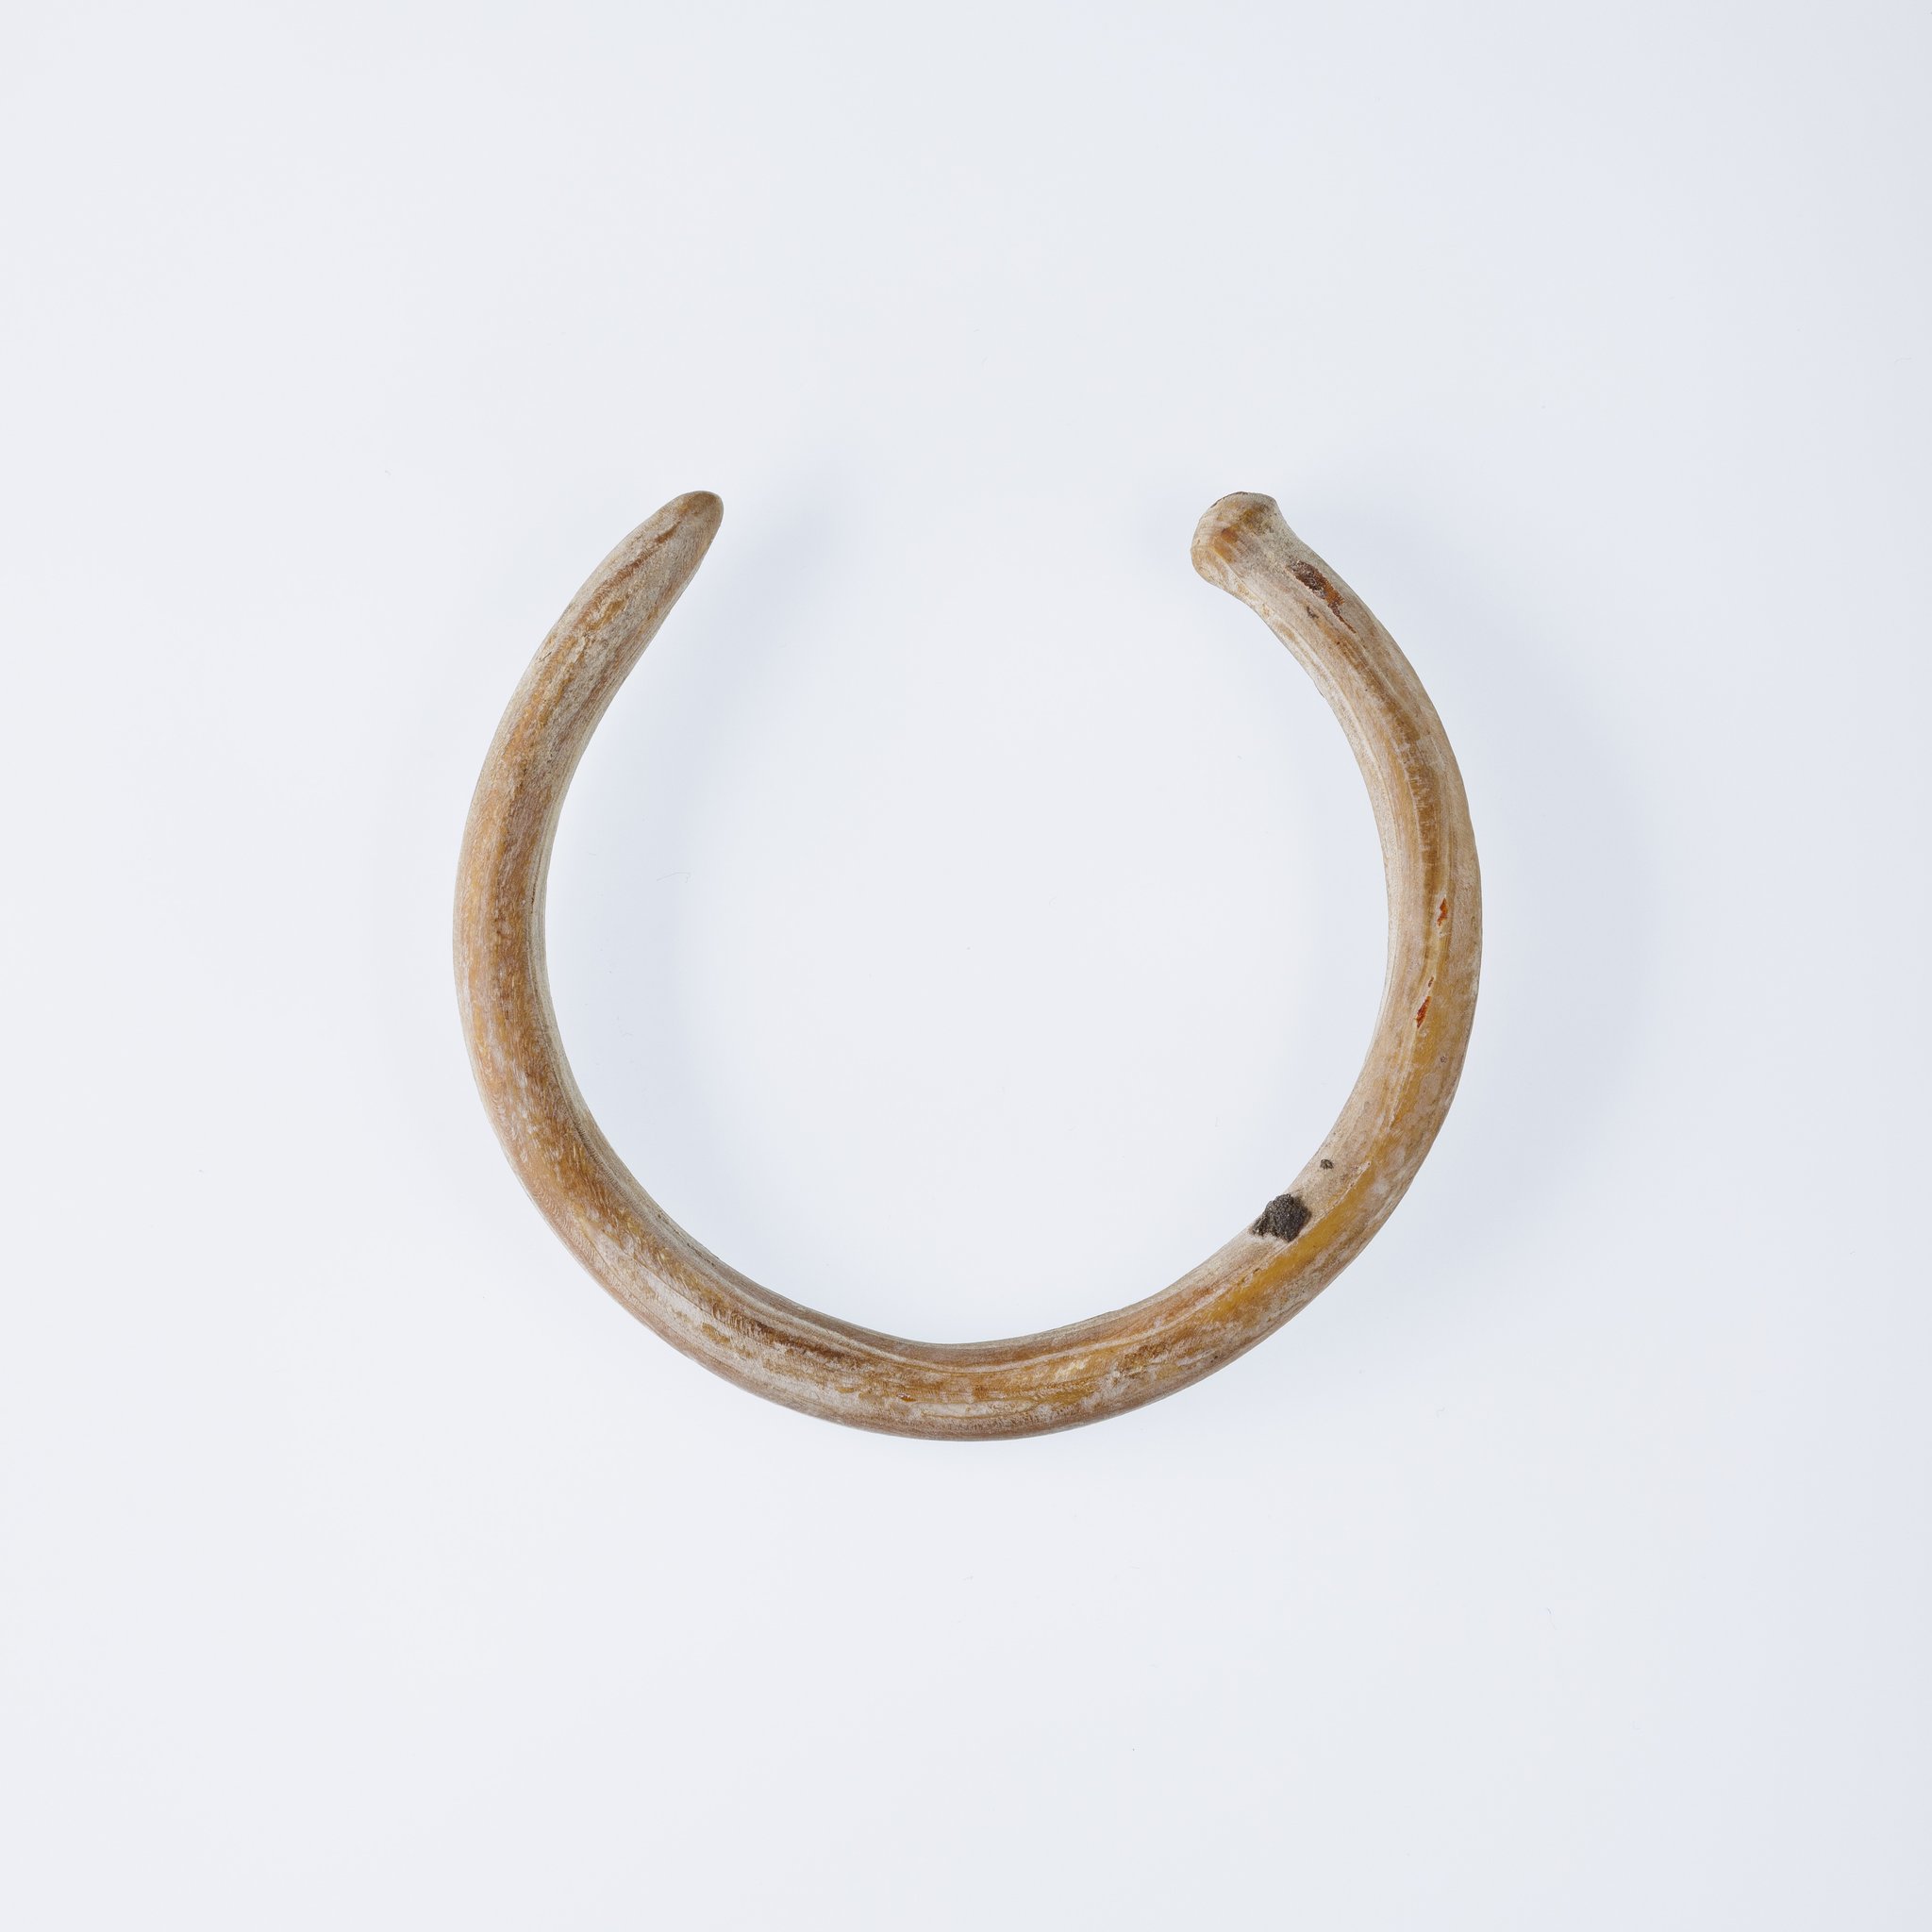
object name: bracelet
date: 4500-4000 BCE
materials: shell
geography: egypt